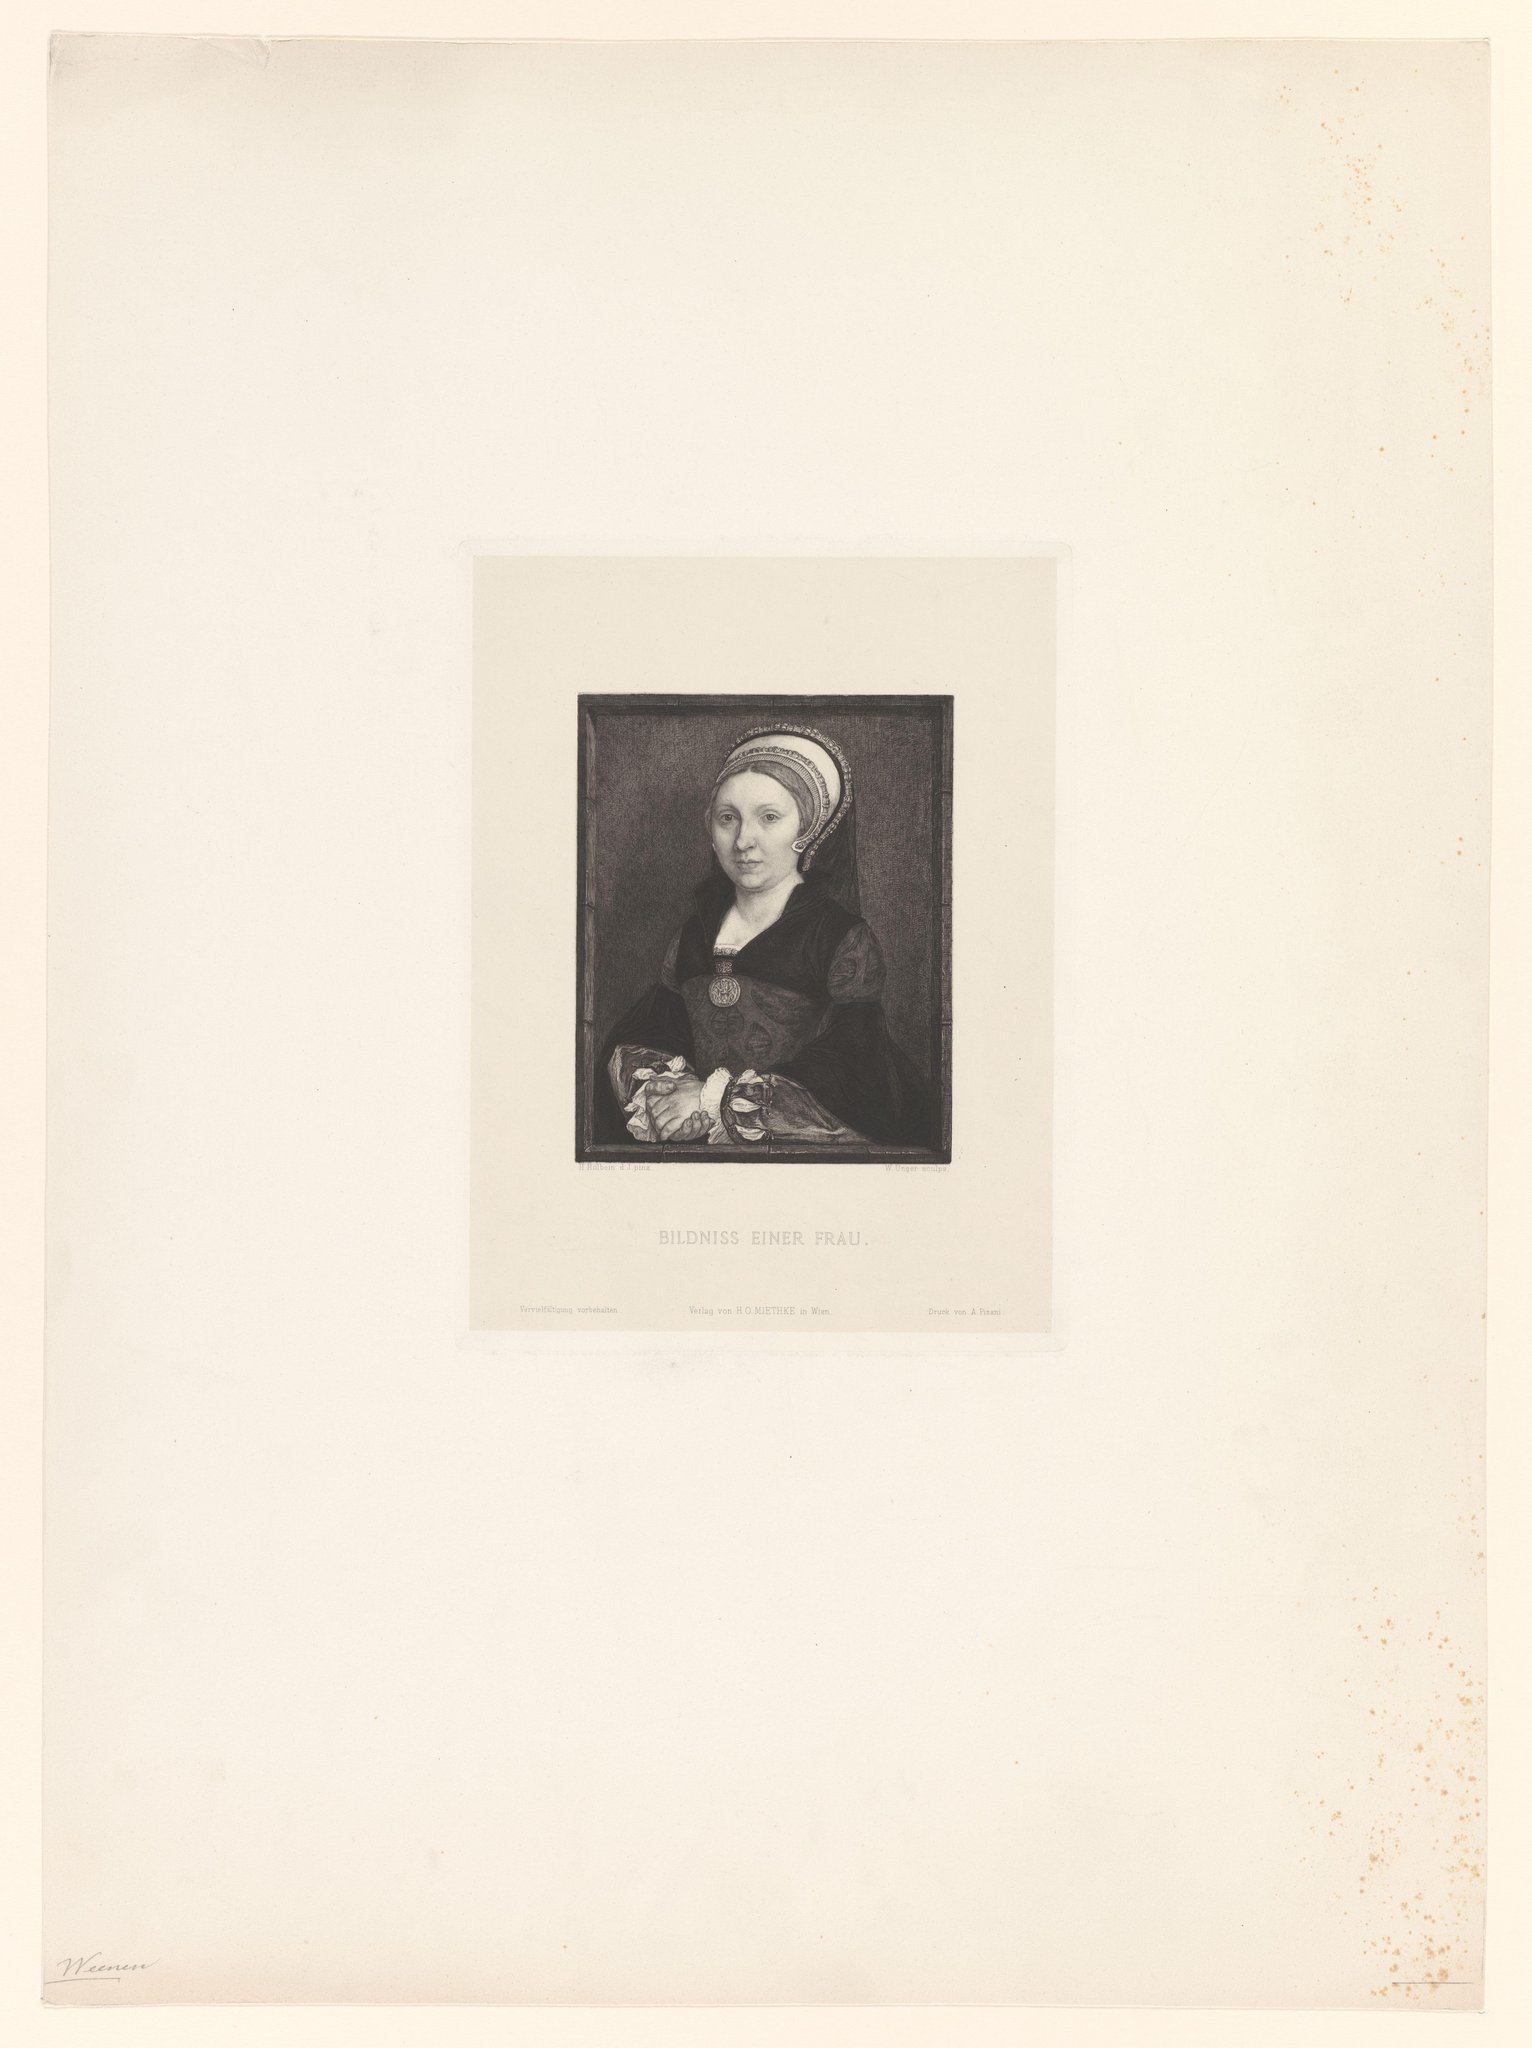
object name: print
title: Portret van een onbekende edelvrouw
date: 1861-1889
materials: paper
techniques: etching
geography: vienna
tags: historical persons - bb - woman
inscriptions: collector's mark: Lugt 2228